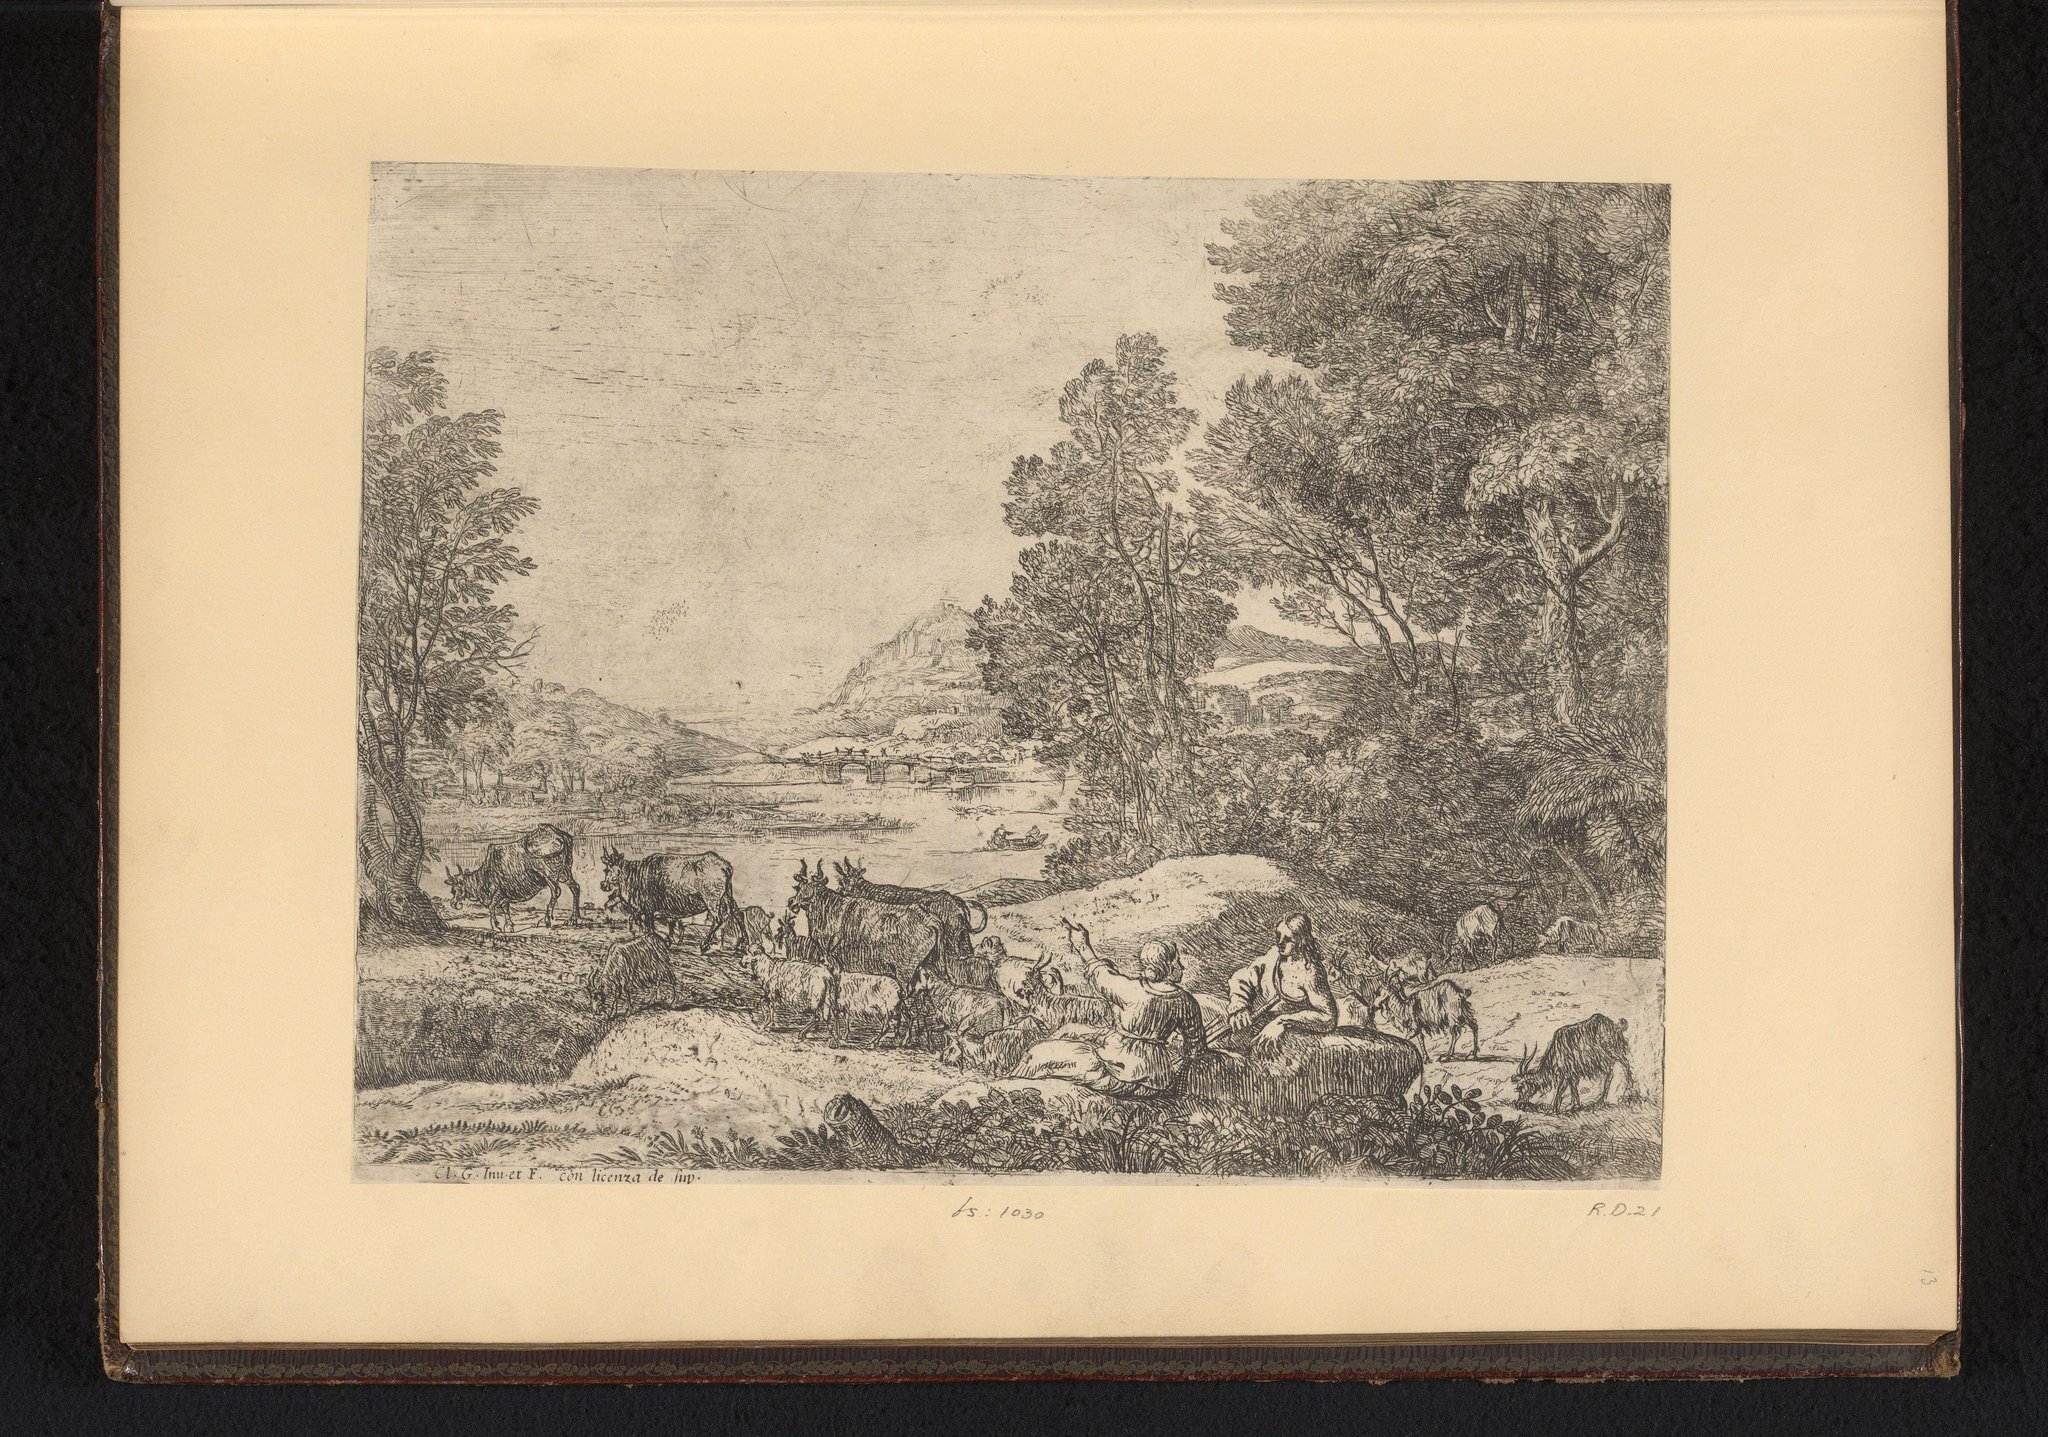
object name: print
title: Herder en herderin in gesprek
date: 1649-1653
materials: paper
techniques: etching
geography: rome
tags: river, herding, herdsman, herdswoman, shepherd, shepherdess, cowherd, etc., herd, flock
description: Prent maakt mogelijk deel uit van een serie van 200 prenten. Deze serie is onder de titel 'A Collection of two hundred original etchings' voor het eerst uitgegeven door J.M. Greery in 1816.